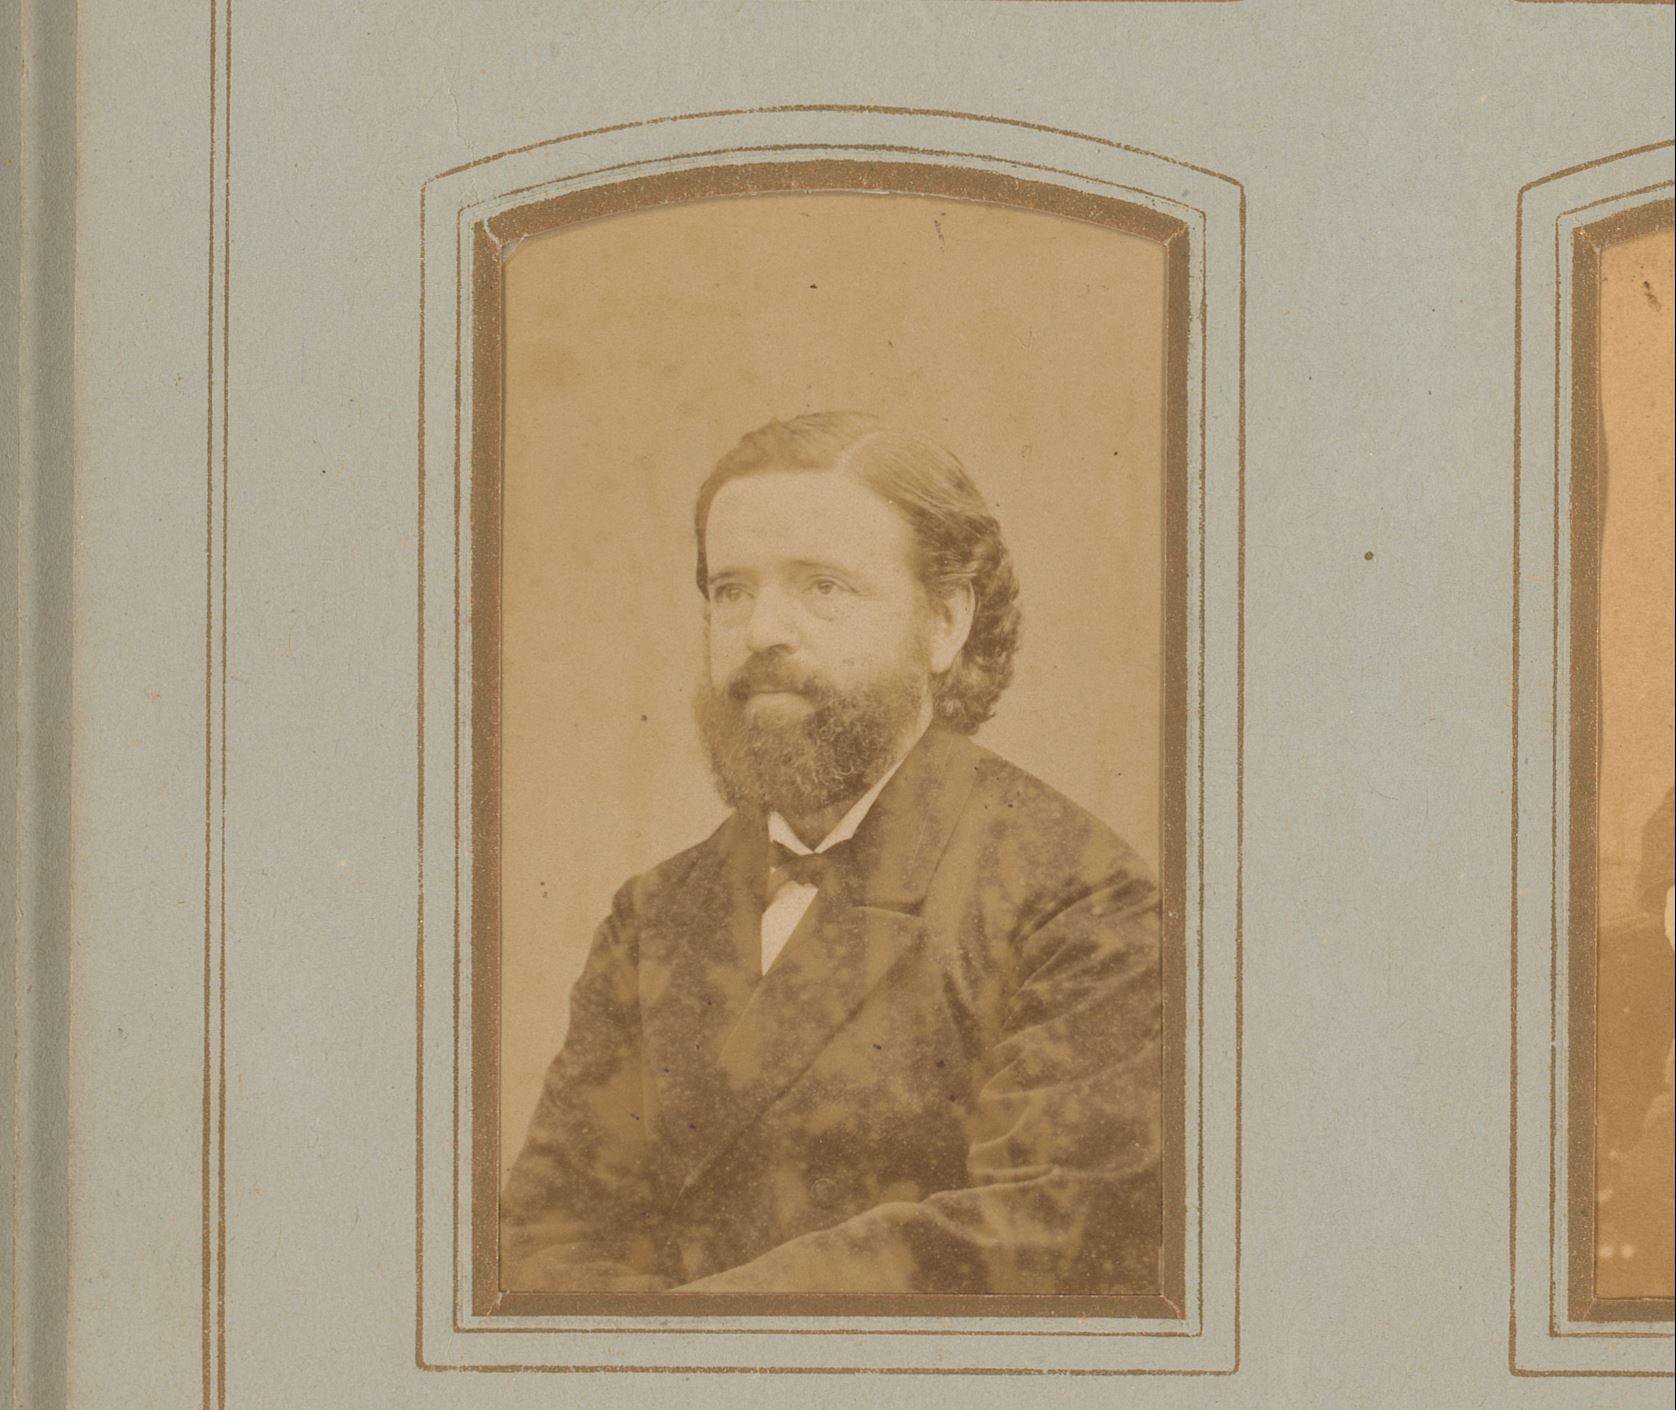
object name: photograph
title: Portret van een man met snor en baard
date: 1857-1894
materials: cardboard, photographic support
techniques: albumen print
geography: edam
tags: moustache, historical persons, beard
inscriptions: inscription: ‘P. SIEWERS en ZOON/ Photograph:/ ATELIER/ EDAM/ Voorhaven/ HILVERSUM/ Badhuis./ Te Edam dagelyks werkzaam./ Te Hilversum Zondags en maandags./ De Plaats wordt voor Nabestelling/ bewaard.’